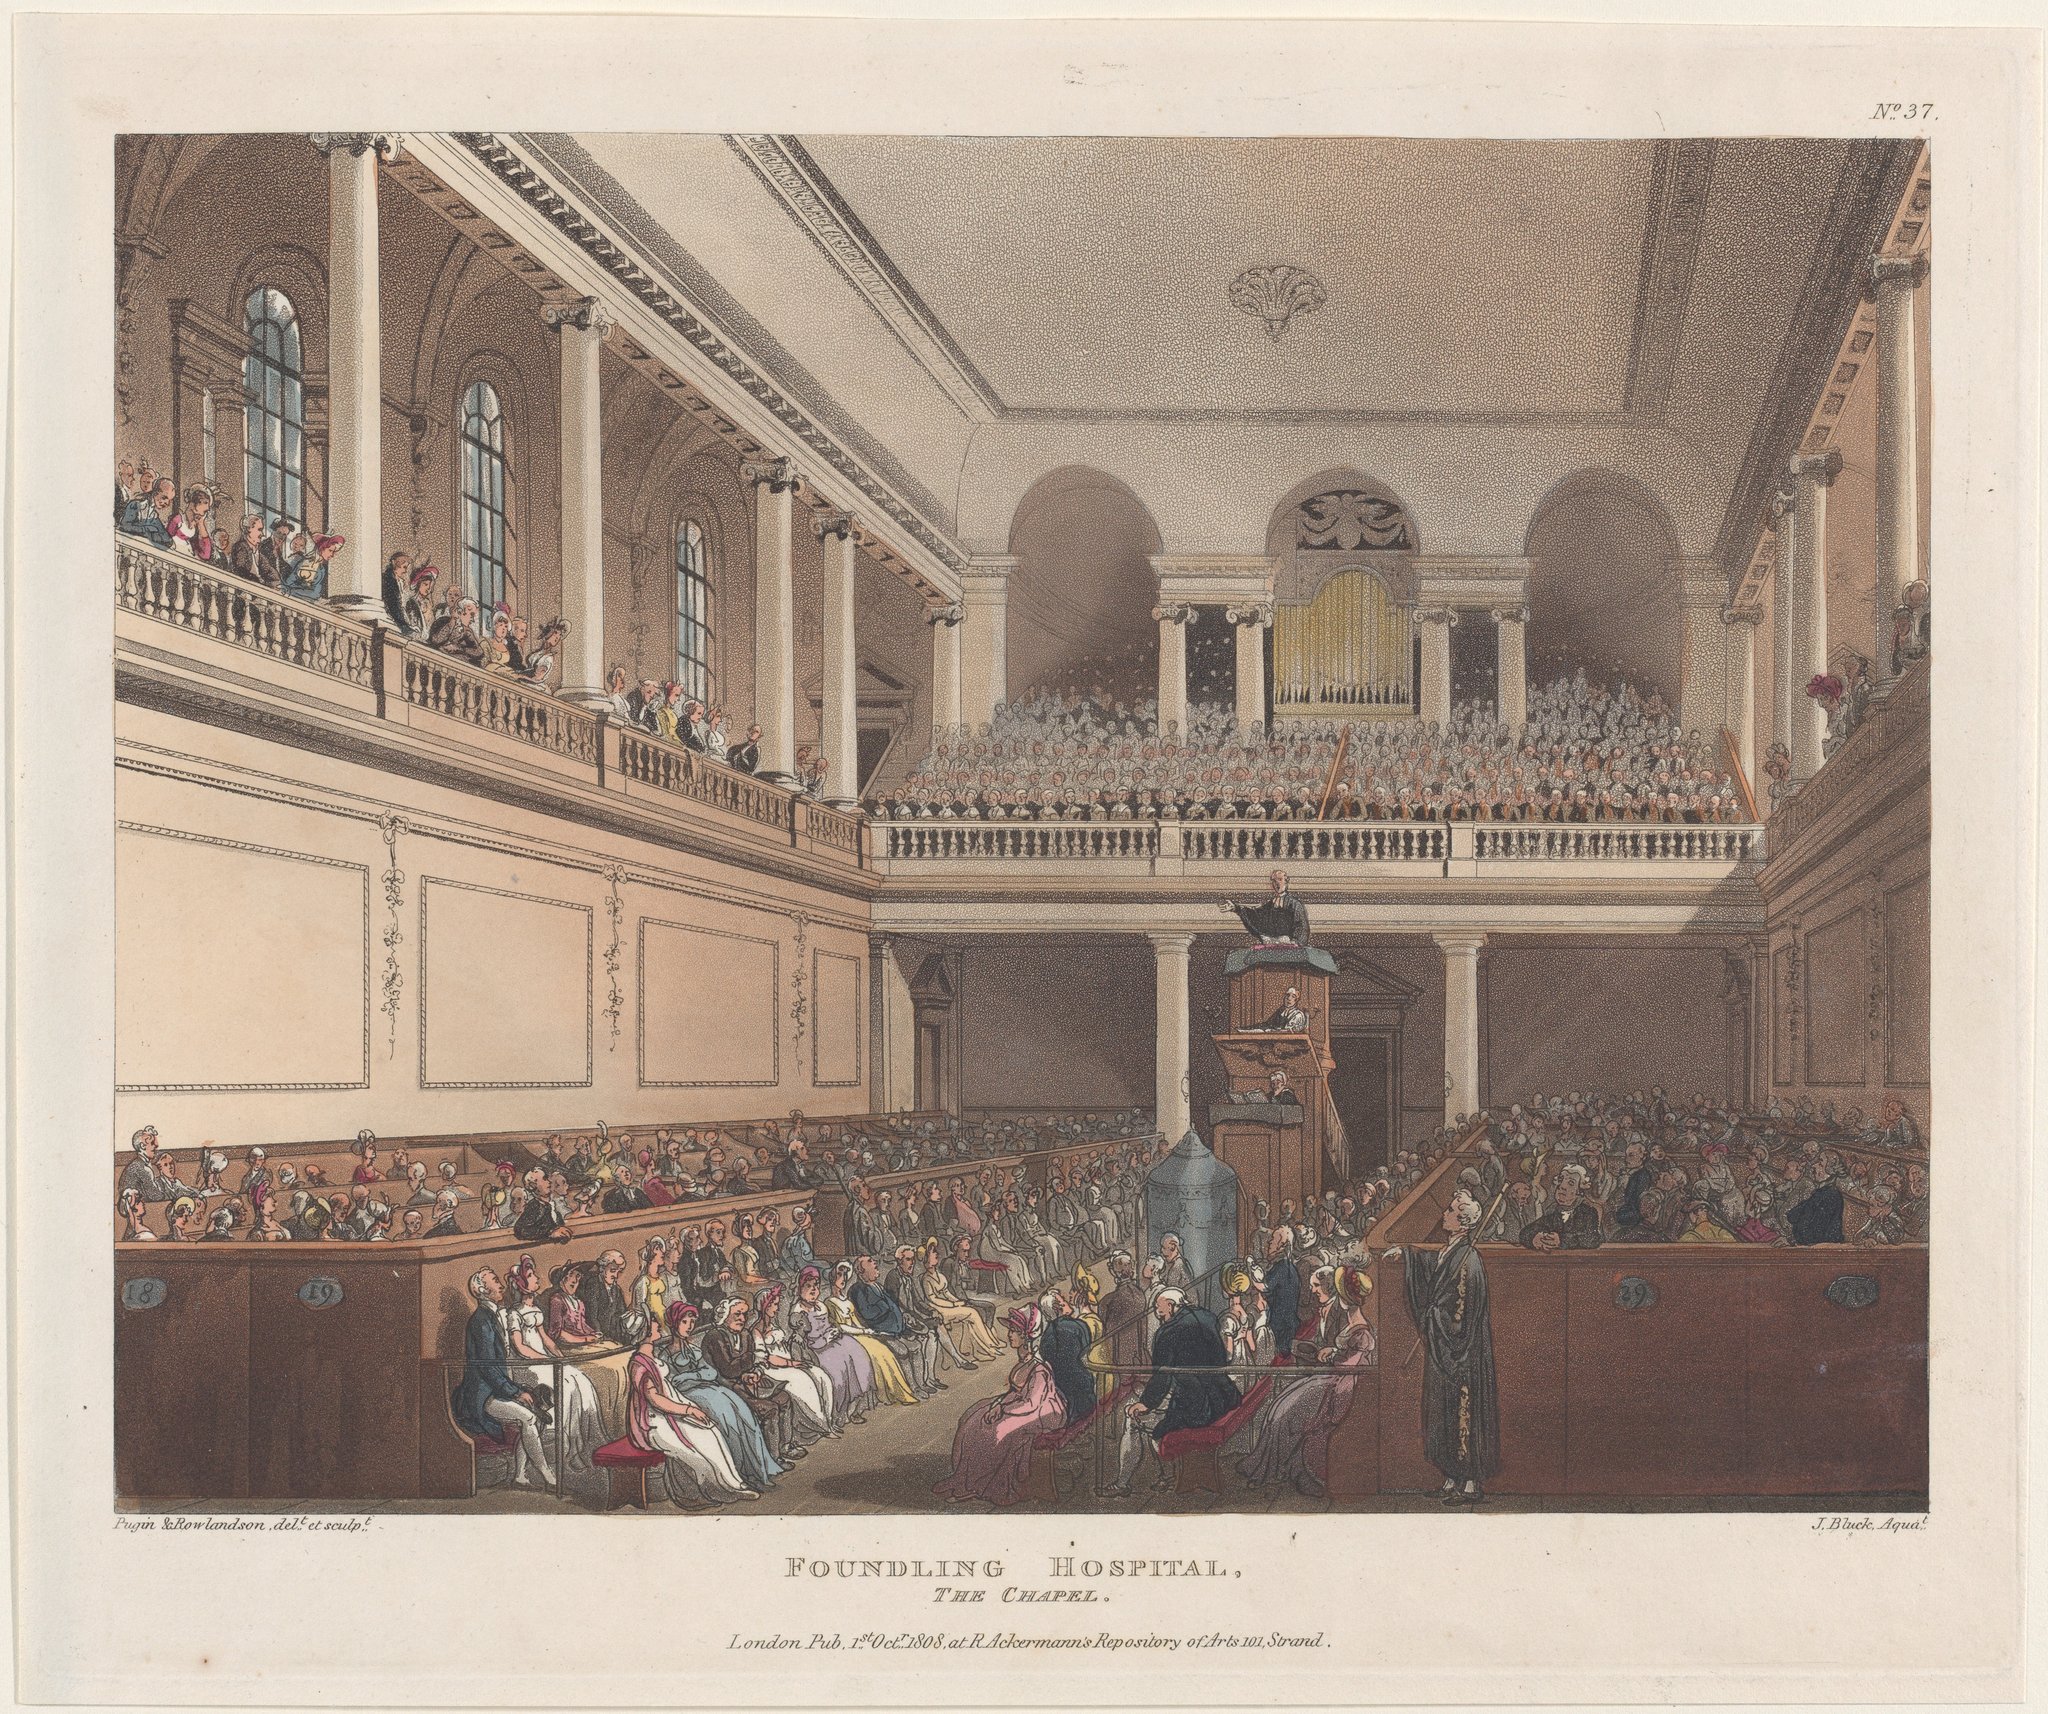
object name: print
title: Foundling Hospital, The Chapel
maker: thomas rowlandson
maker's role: artist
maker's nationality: british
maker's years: 1757-1827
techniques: aquatint, etching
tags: interiors,chapels